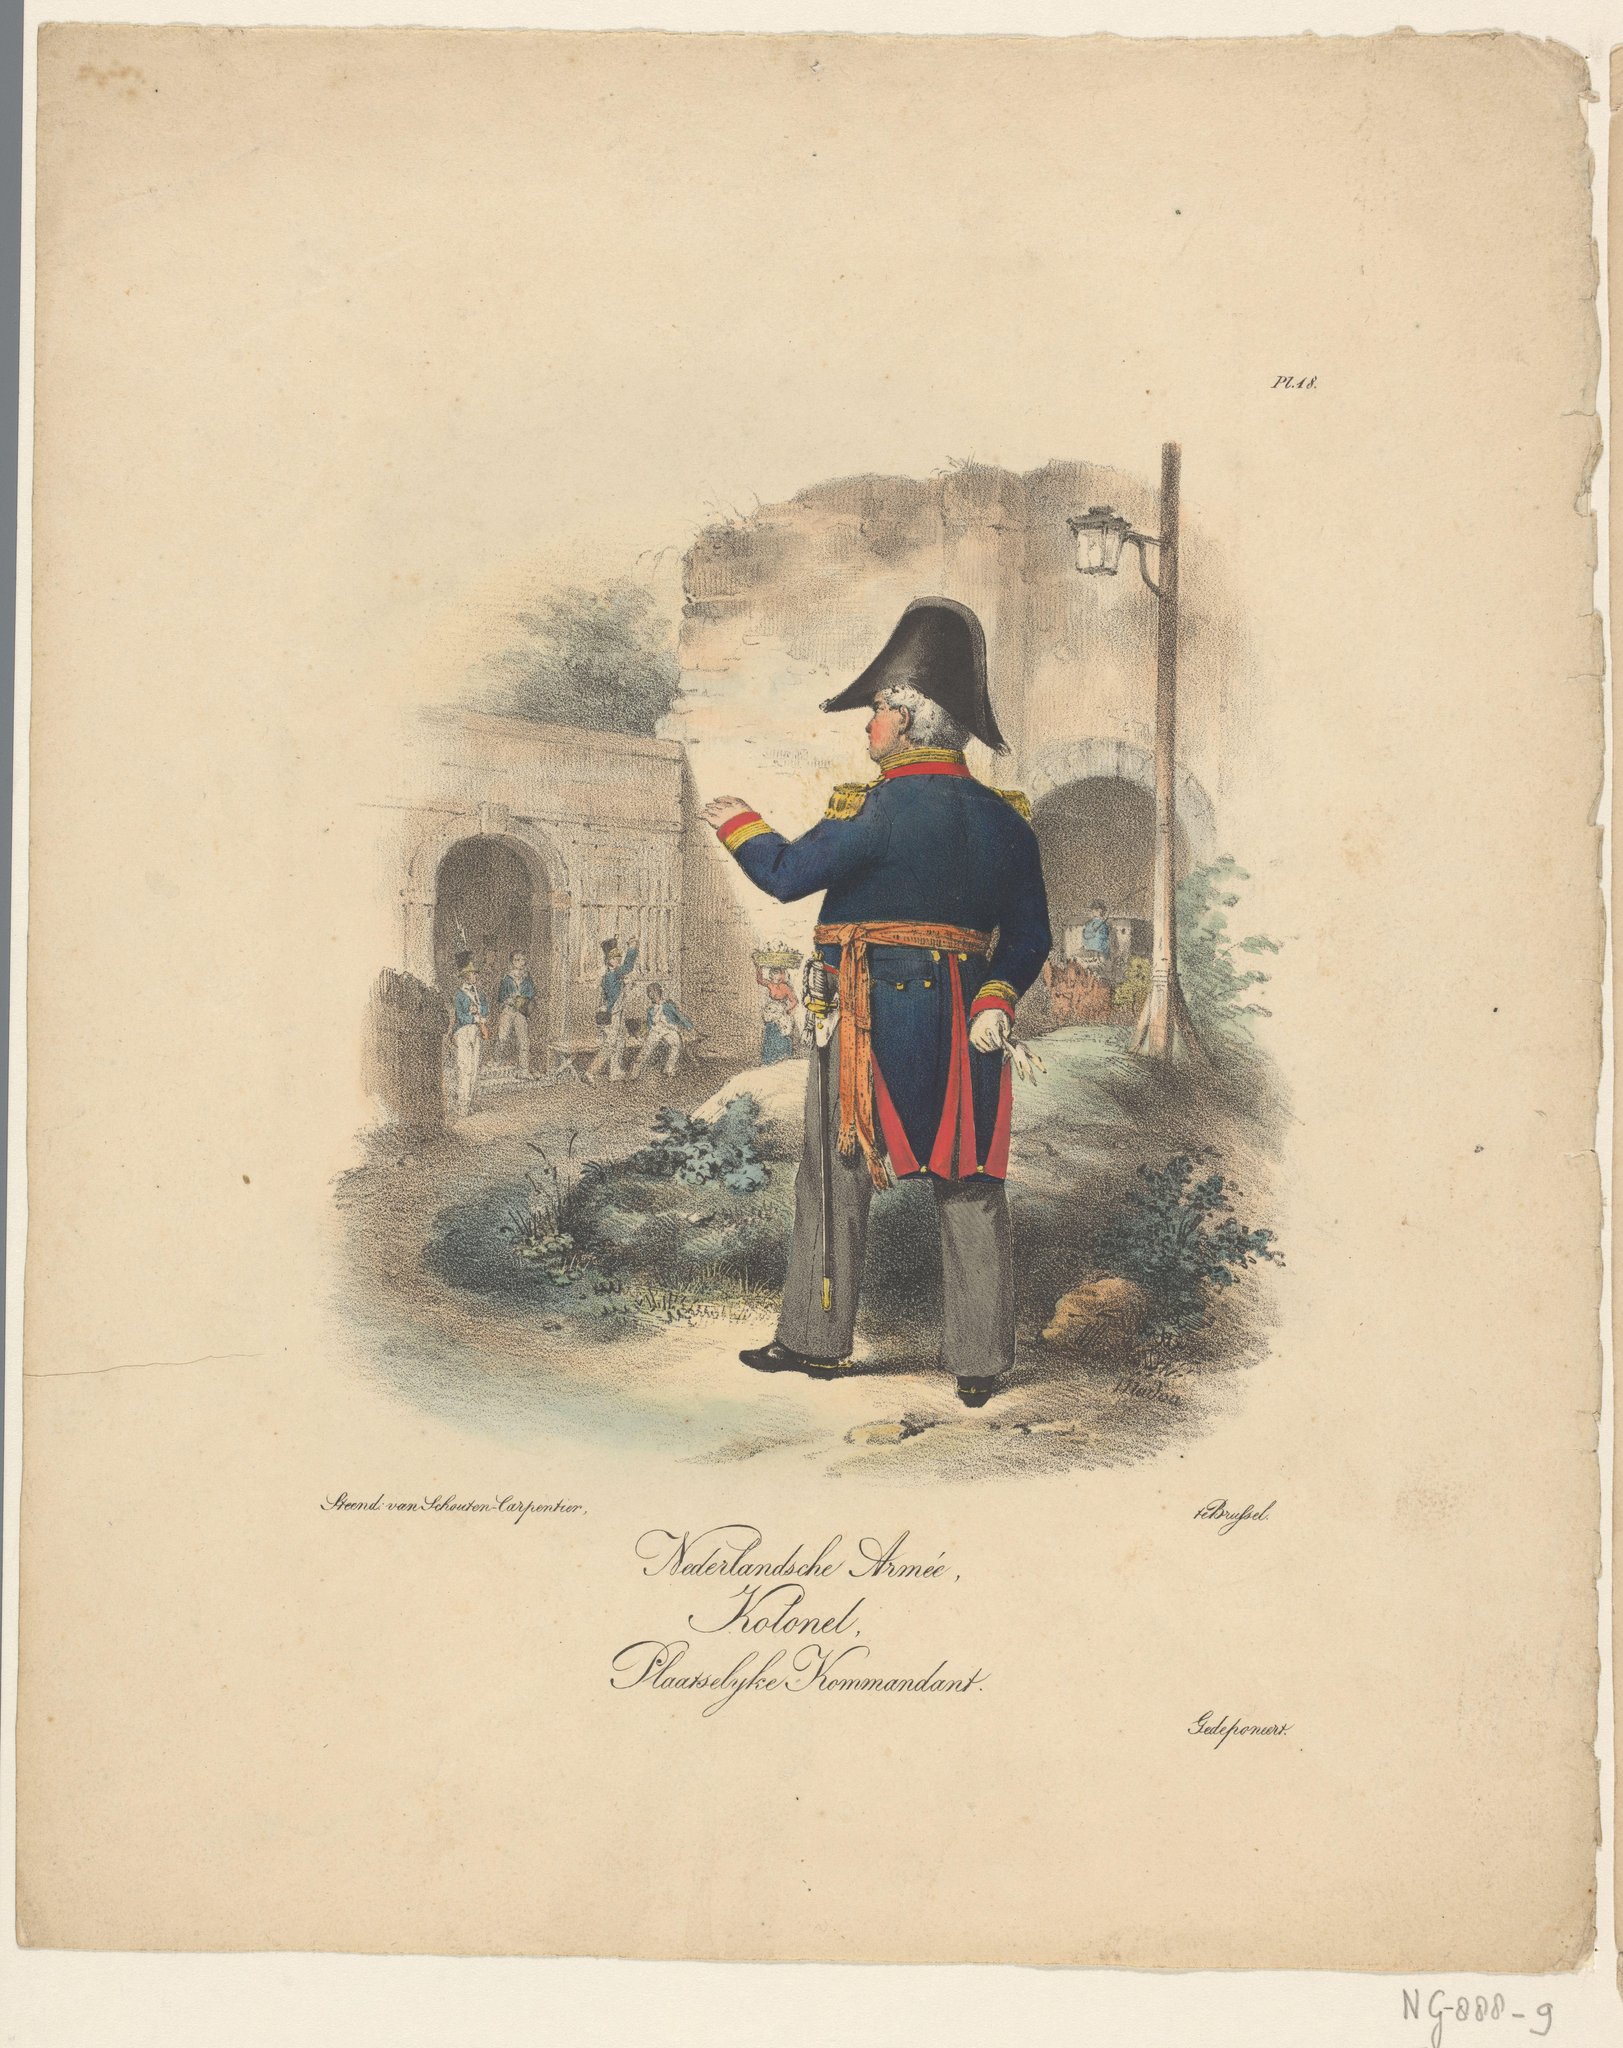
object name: costume print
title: Militaire costumen van het Koninkryk der Nederlanden : opgedragen aan zyne excellentie Willem van Bylandt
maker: jean baptiste madou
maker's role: draughtsman, painter, print maker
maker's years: 1796-1877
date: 1823-1827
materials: paper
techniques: hand coloring, lithograph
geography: brussels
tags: (military) uniforms (+ infantry)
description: Een plaatselijk commandant, kolonel, op de rug gezien. Op de achtergrond soldaten bij een stadspoort. Genummerd rechtsboven: 18. Afkomstig uit een plaatwerk van uniformen van het Nederlandse leger, ca. 1825.